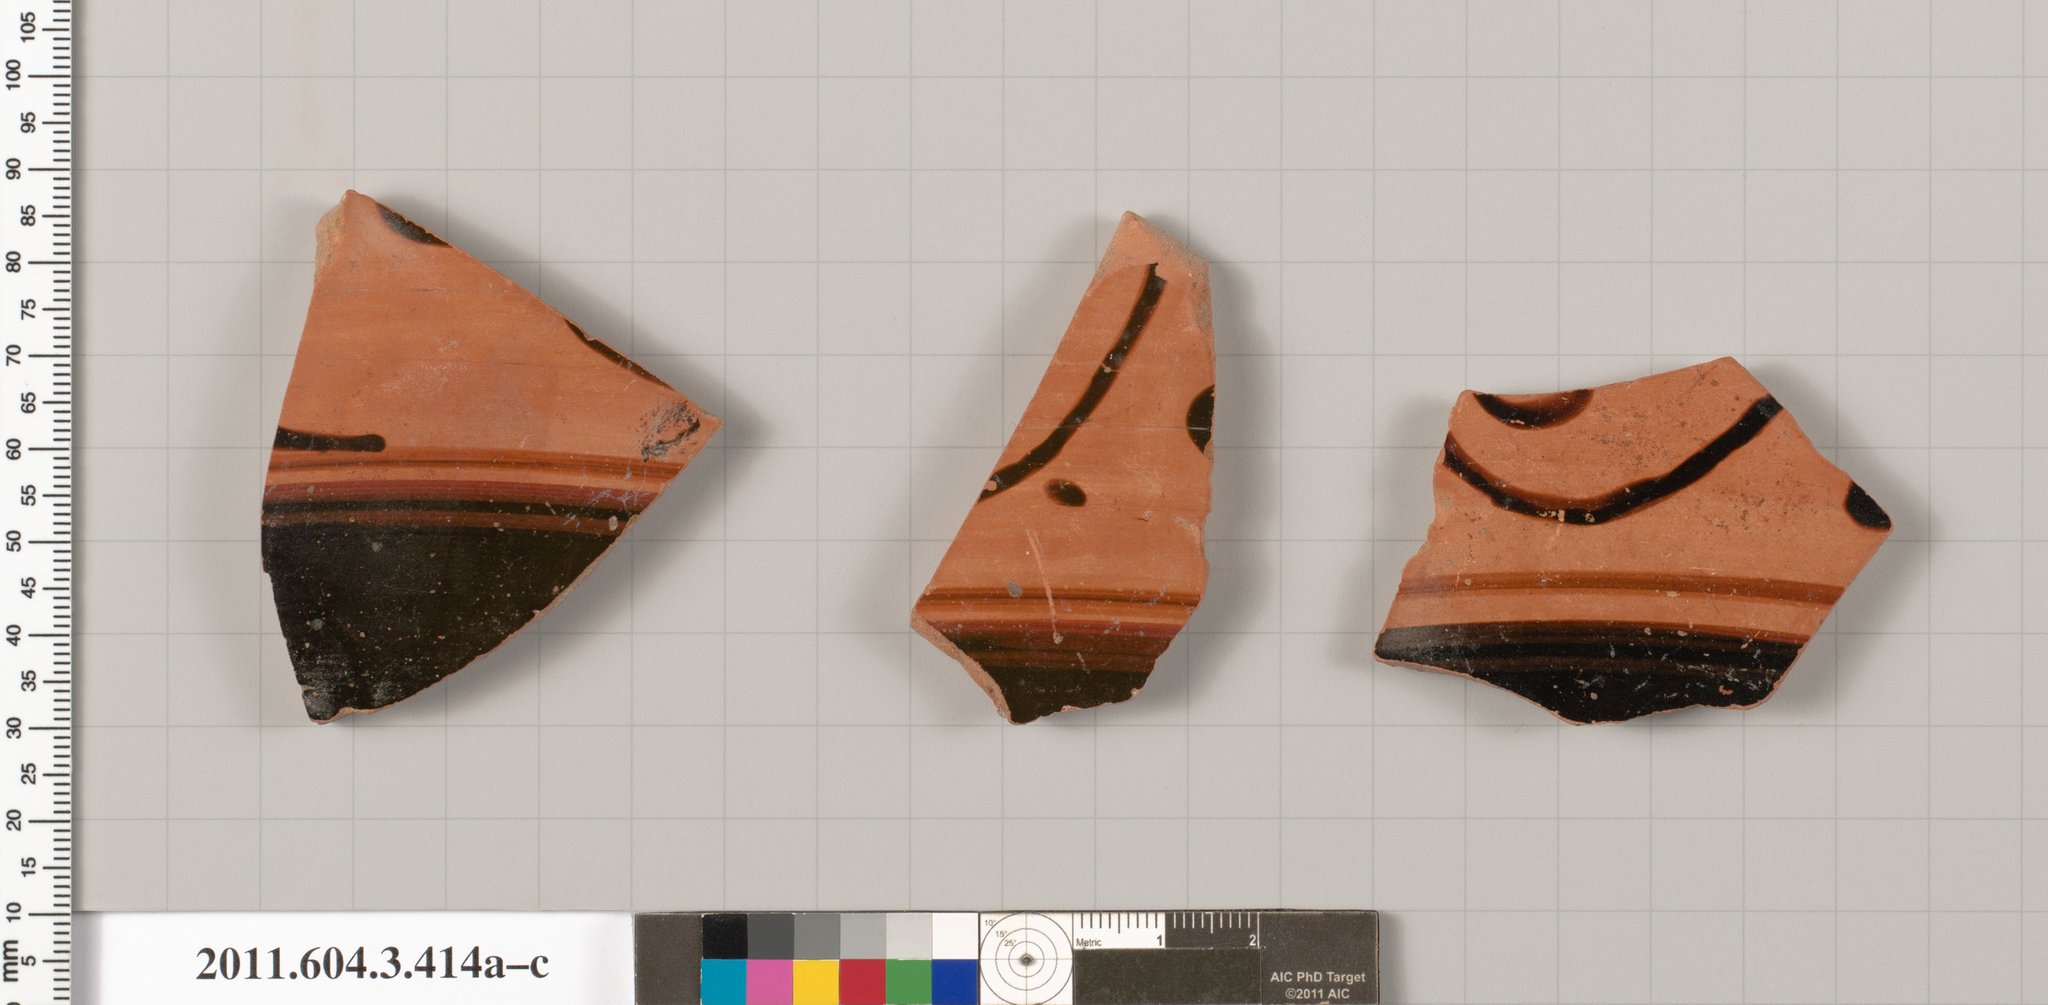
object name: neck amphora fragment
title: Terracotta fragments of a neck-amphora (jar)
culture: greek, attic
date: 500-468 BCE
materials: terracotta